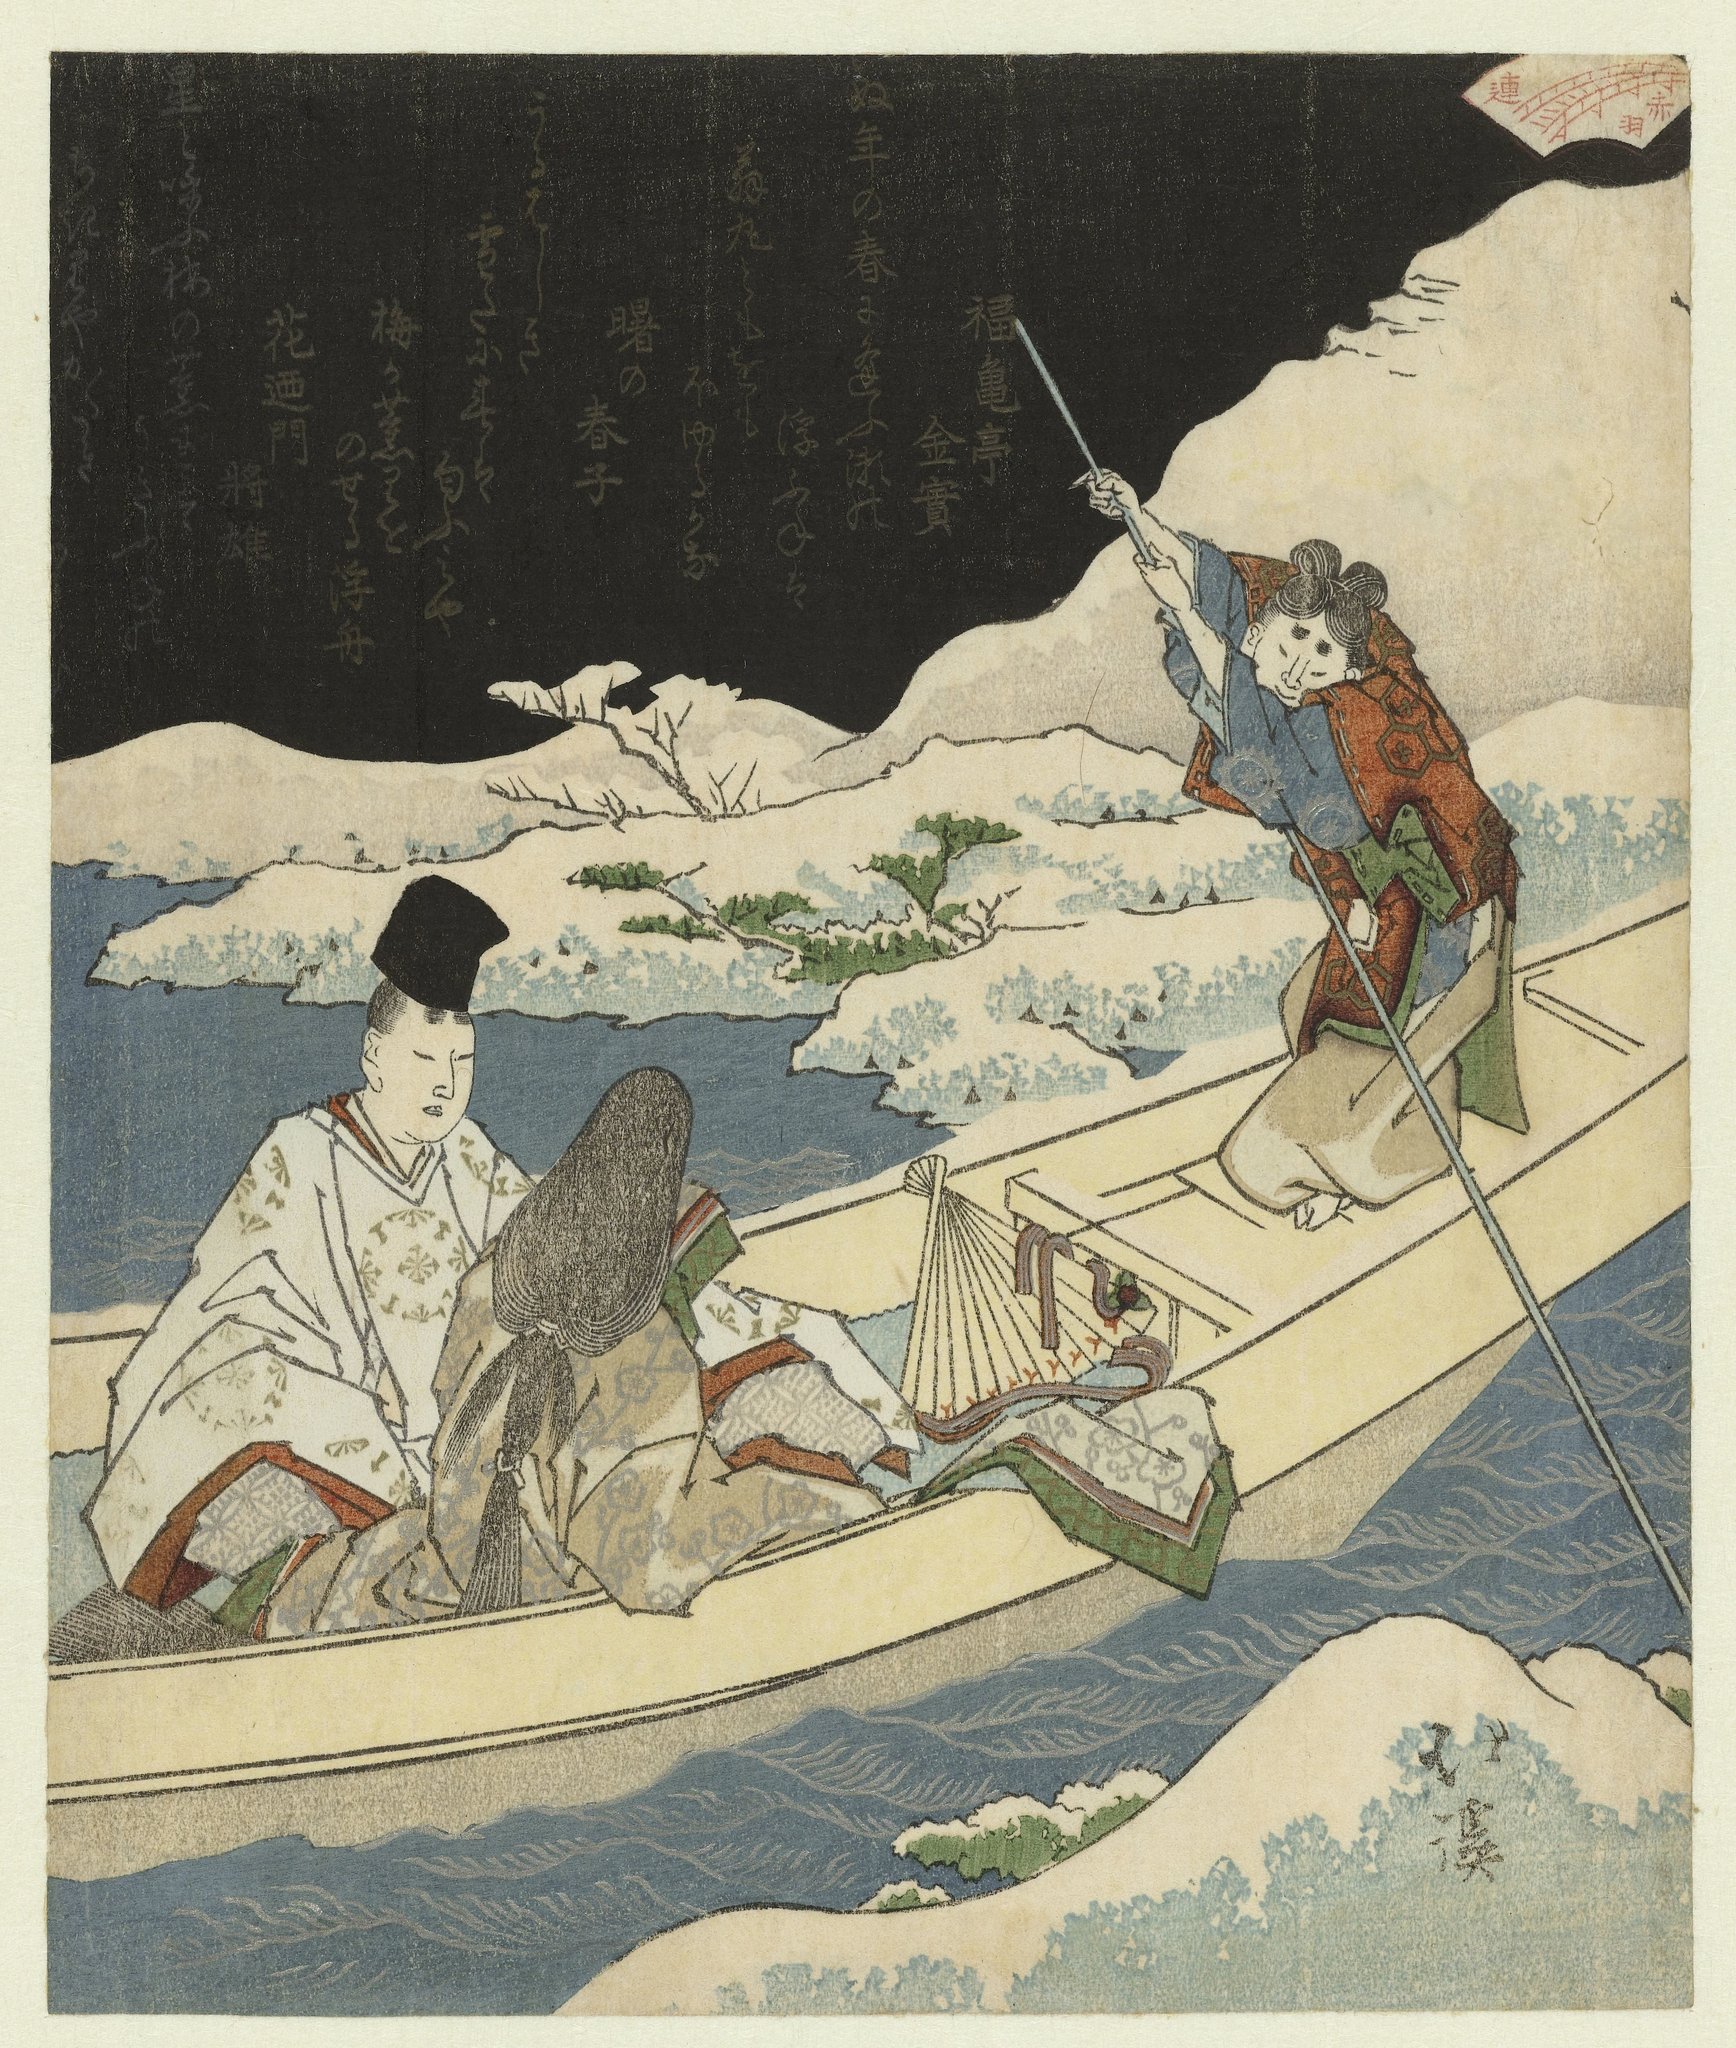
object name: surimono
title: The Nightly Boat Outing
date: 1826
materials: paper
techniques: woodcut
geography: japan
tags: snow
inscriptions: collector's mark, passe-partout, bottom left, printed: JABdH with a rooster., collector's mark, verso, stamped: Lugt 2228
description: Hofdame en edelman op een nachtelijke vaart door een besneeuwd landschap. deze scene verwijst naar hoofdstuk 51 'Ukifune' uit Het verhaal van Genji. In deze aflevering gaat de kleinzoon van Genji, prins Niou er op een nacht met de dame Ukifune vandoor. Het verhaal van Genji (Genji monogatari) is geschreven in de Heian periode (794-1185) door de hofdame Murasaki Shikibu. Met drie gedichten.